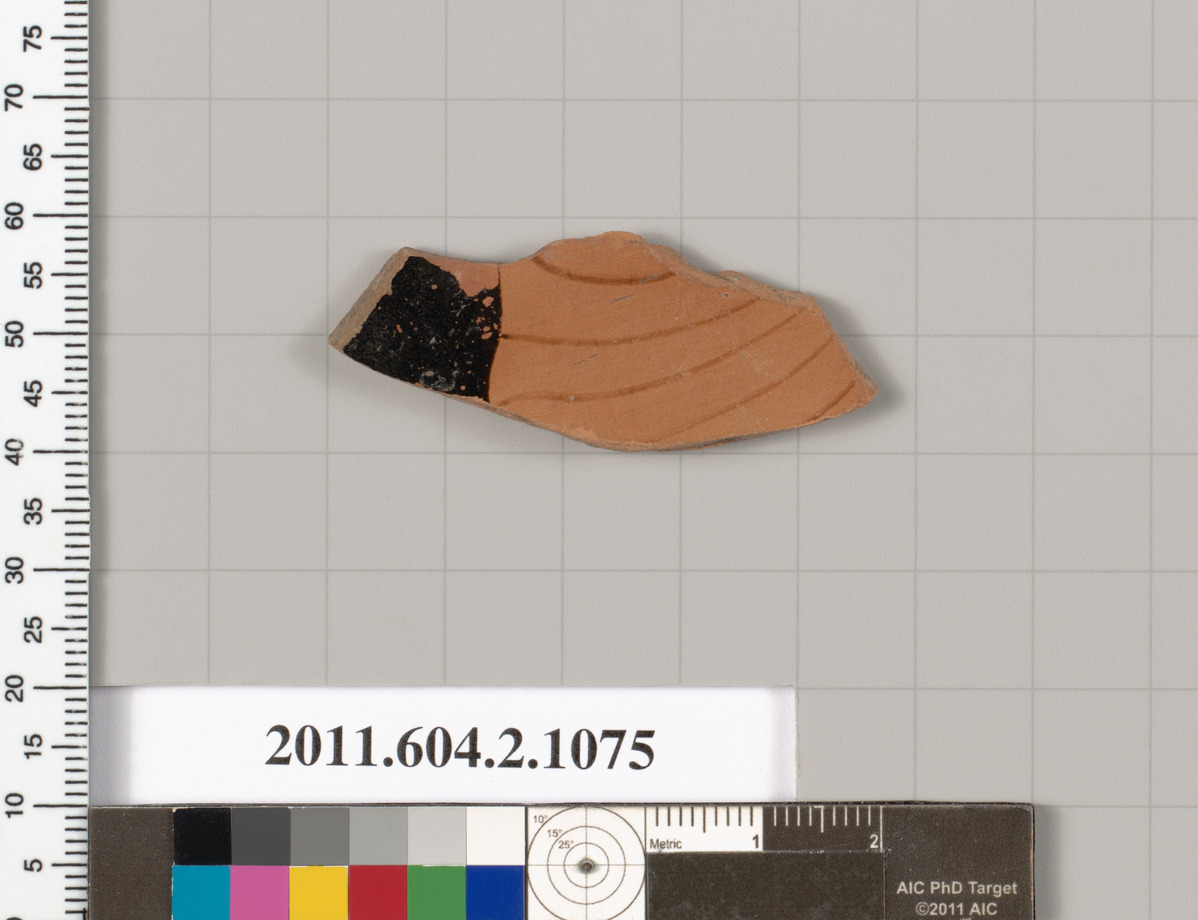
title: Terracotta fragment of a closed shape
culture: greek, attic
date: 450-430 BCE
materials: terracotta